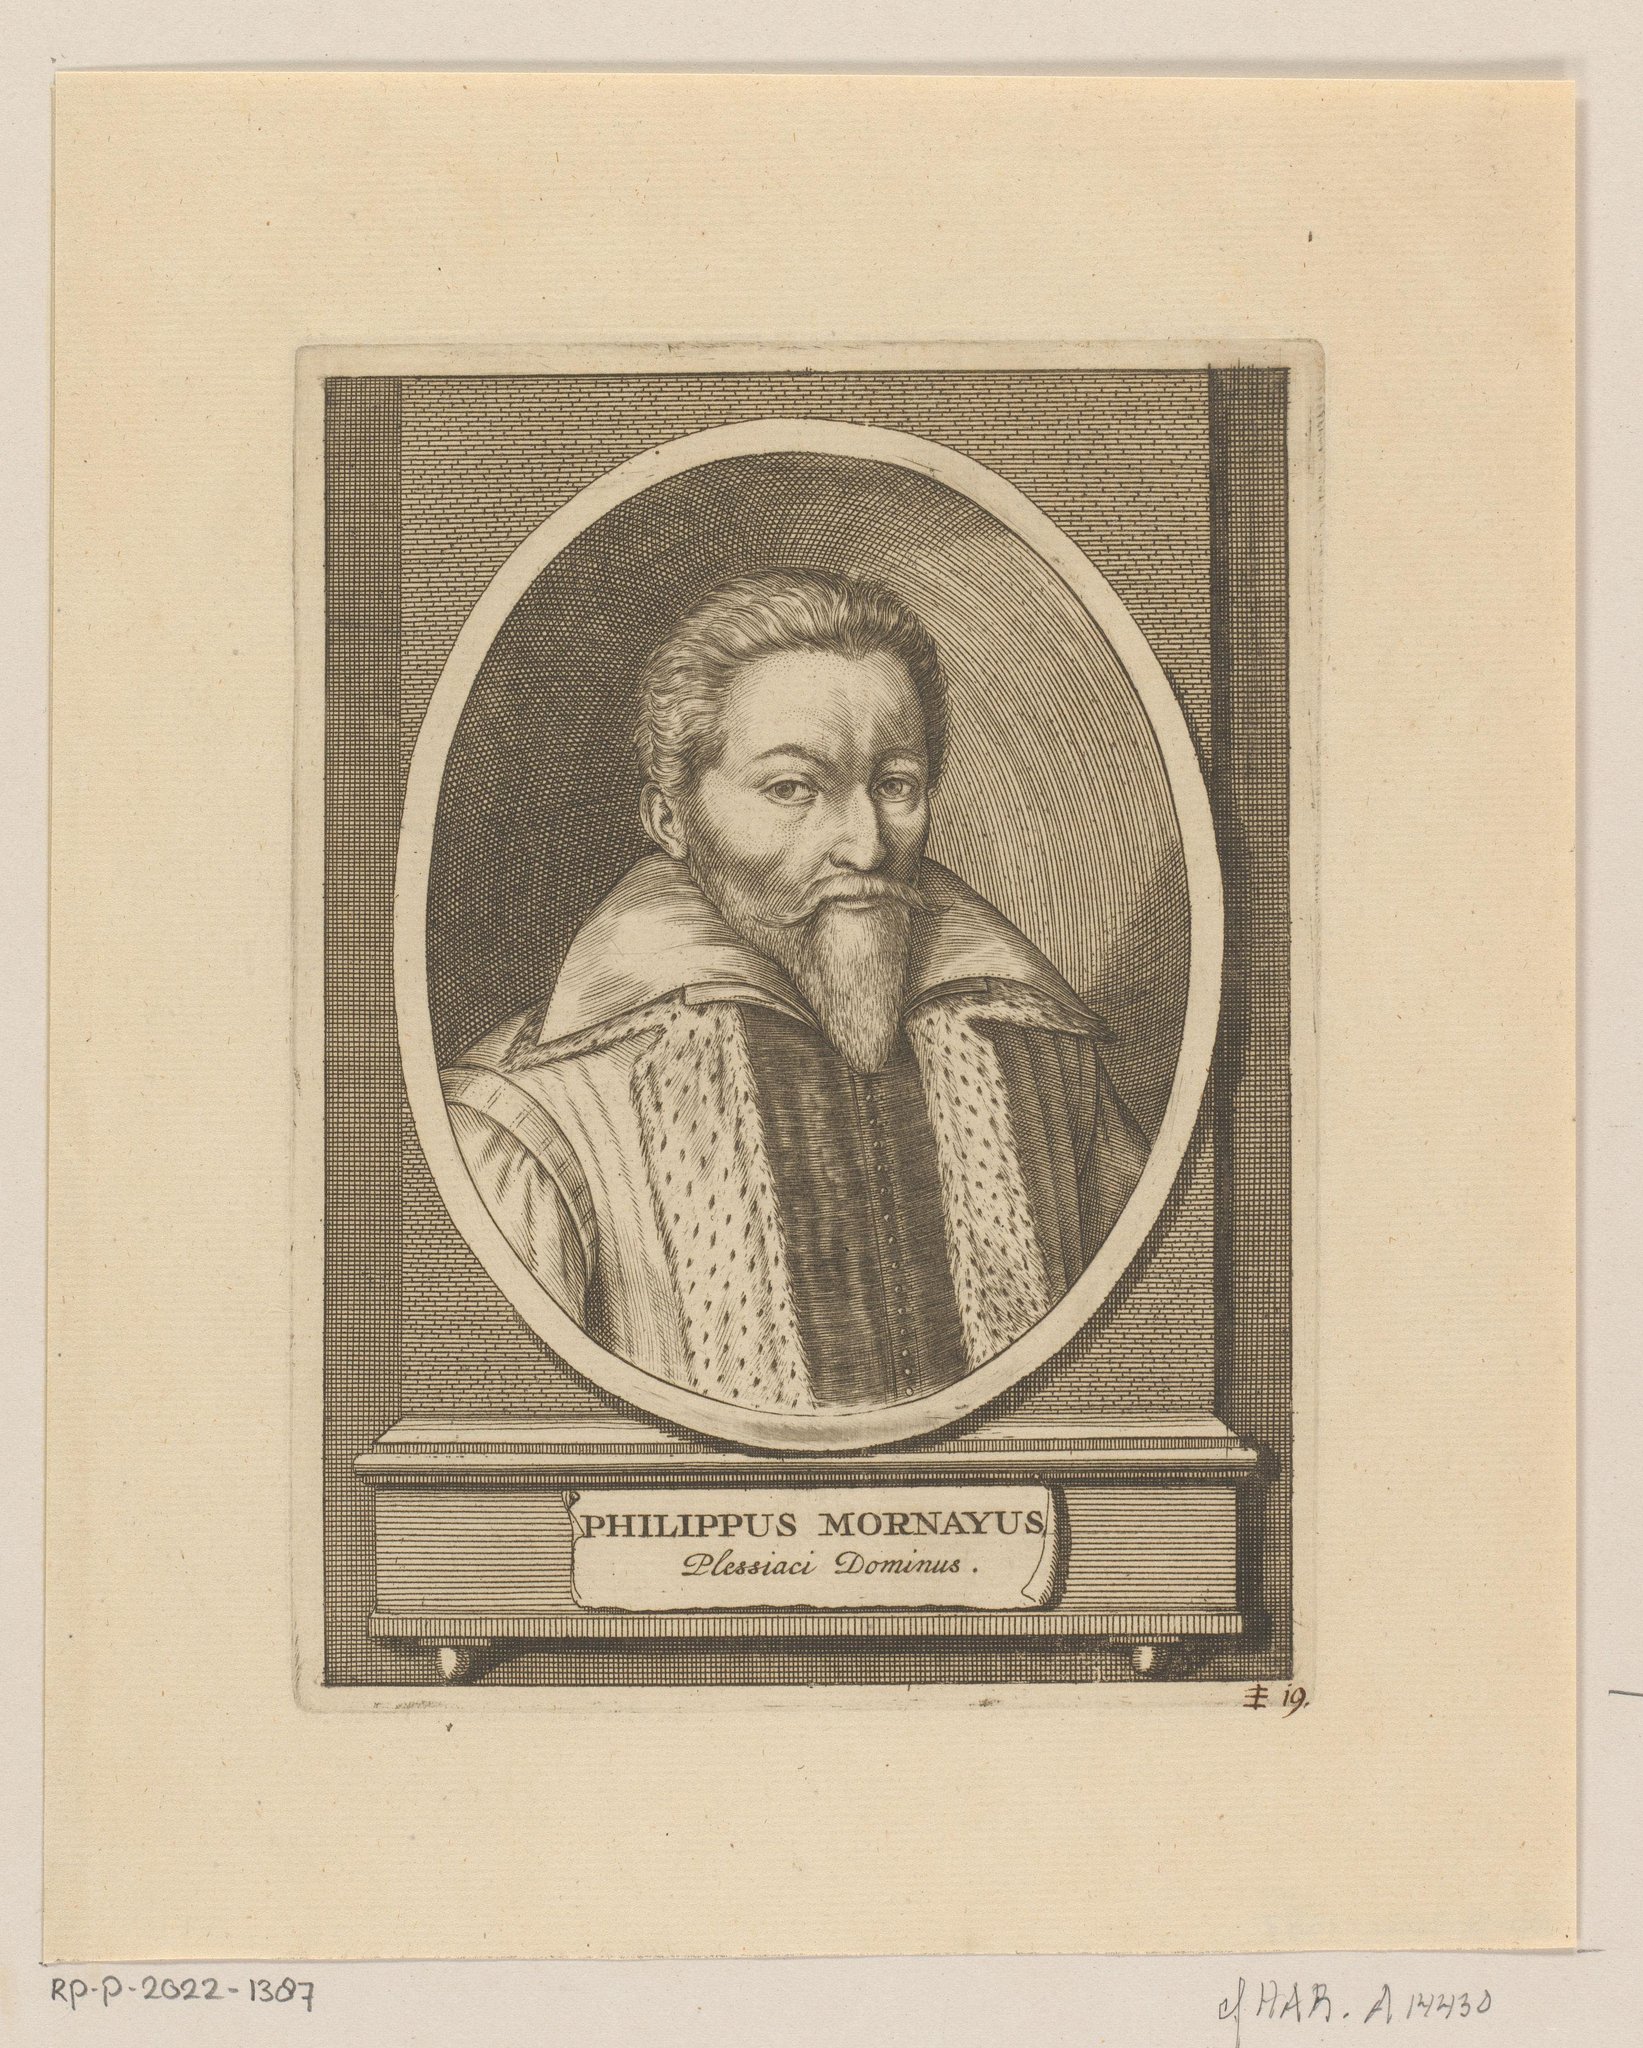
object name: print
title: Portret van Philippe du Plessis-Mornay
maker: Anonymous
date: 1720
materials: paper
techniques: engraving, etching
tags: theologian, historical persons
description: Prent waarschijnlijk uit: Imagines XLI. Virorum Celebriorum in Politicis Historicis &c. Leiden: Pieter van der Aa, 1720.